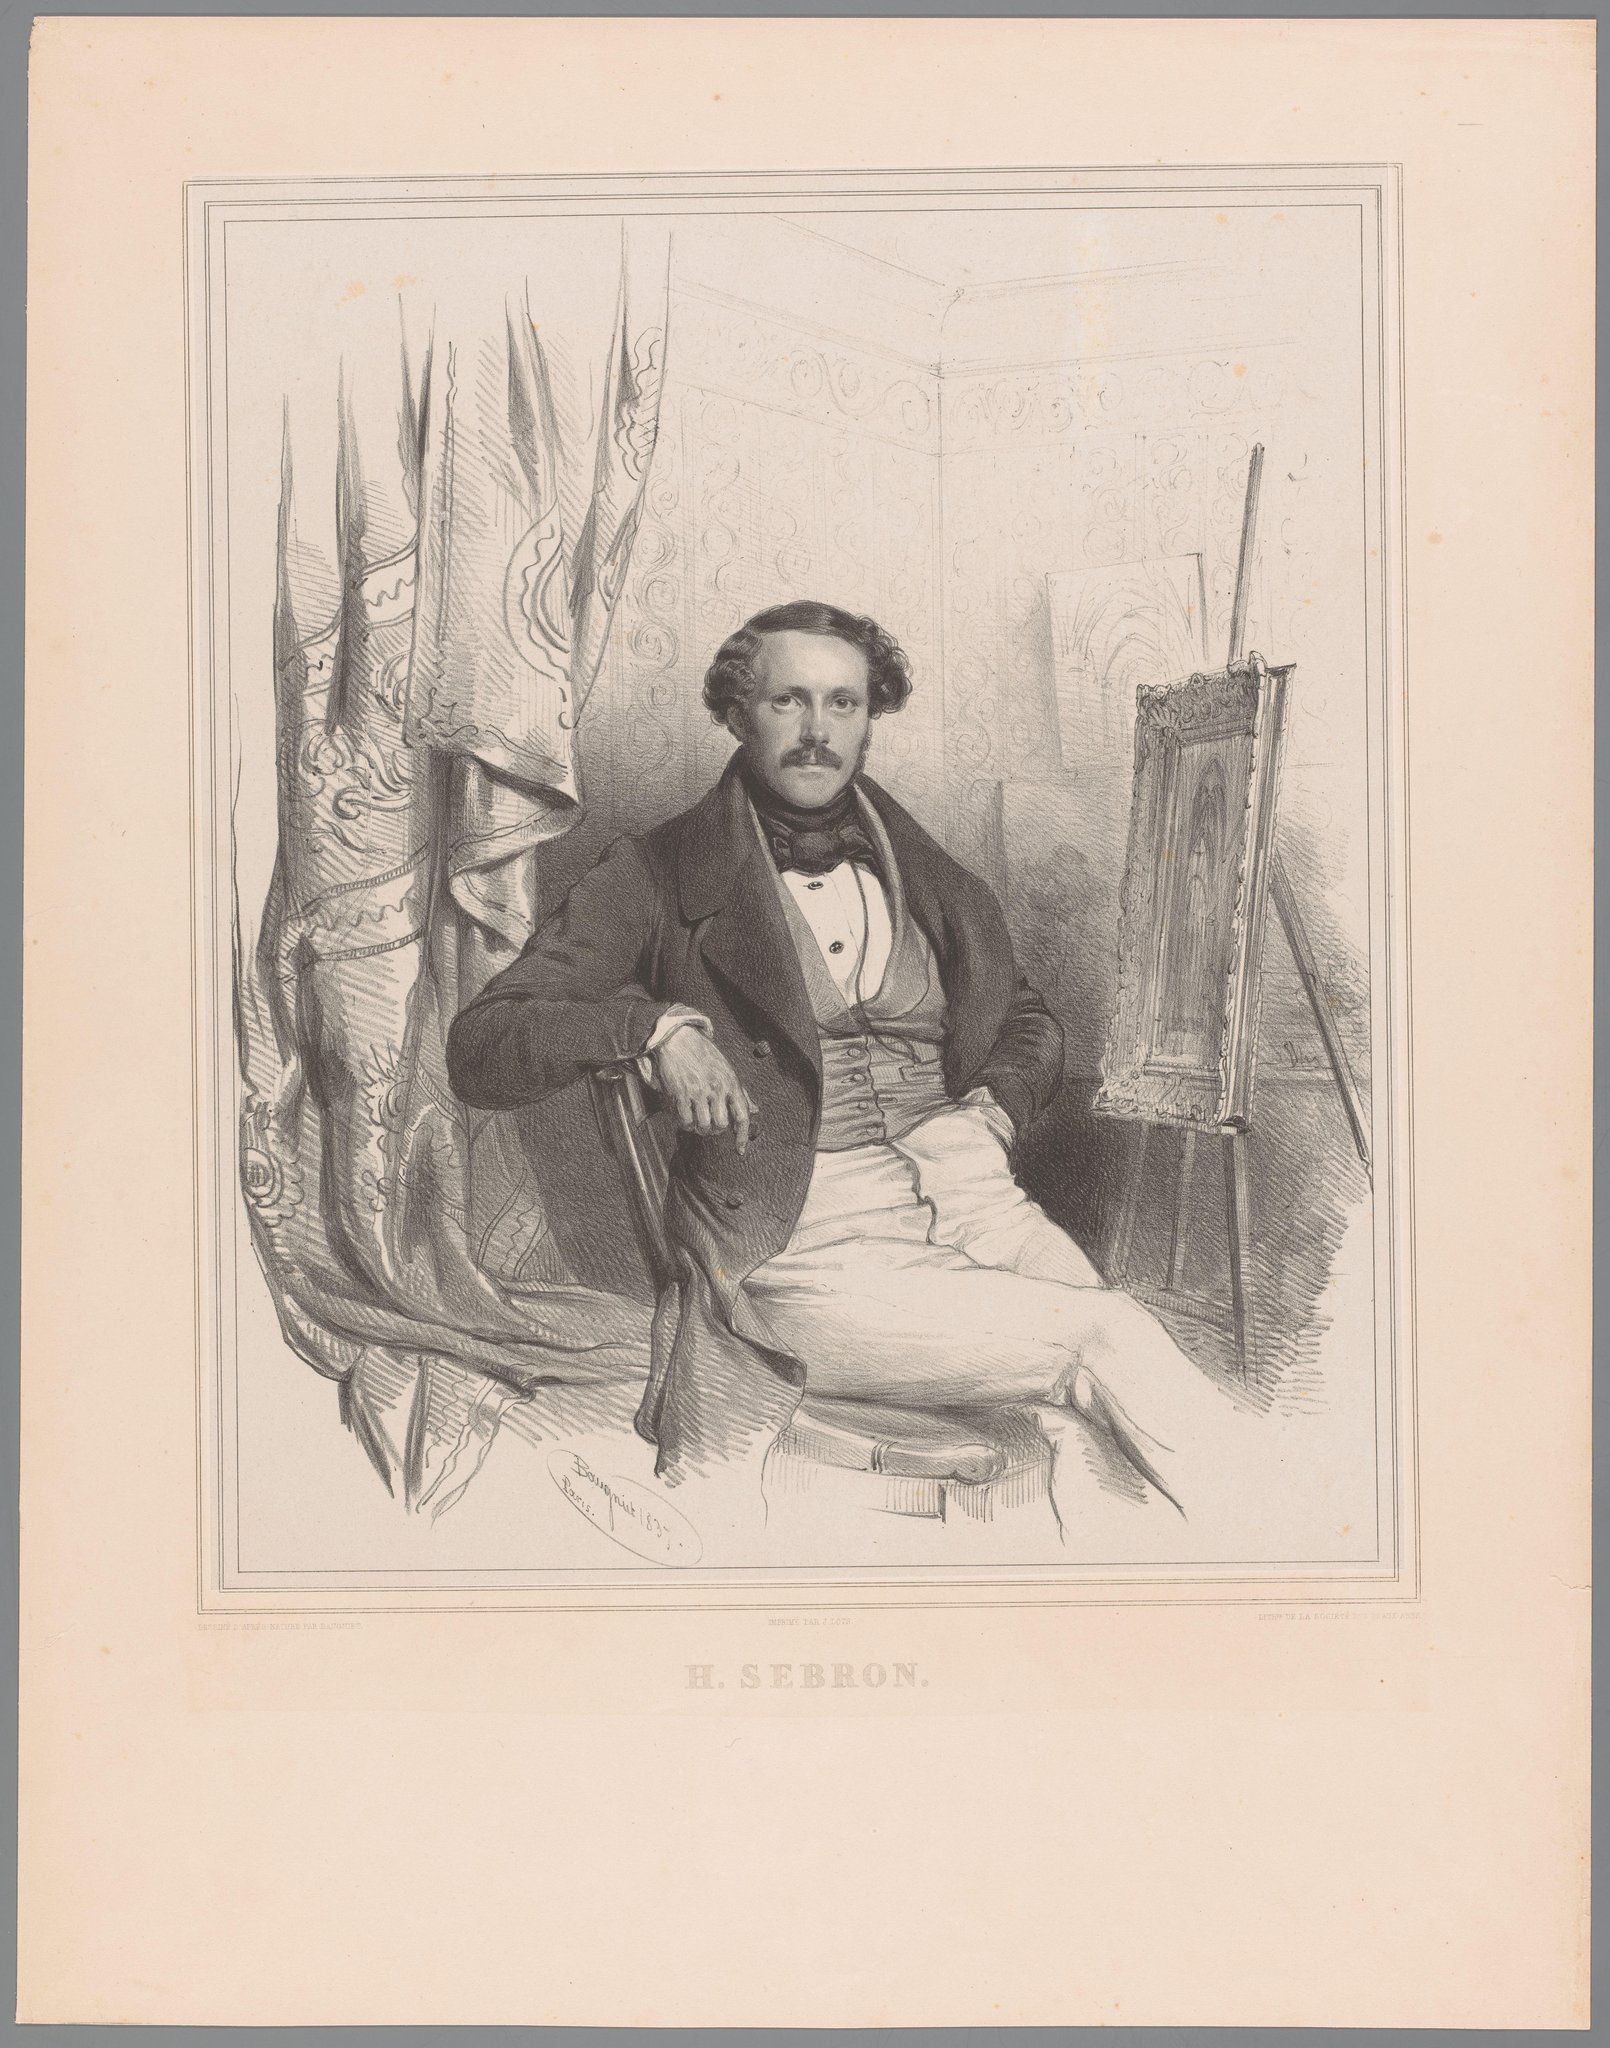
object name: print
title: H. Sebron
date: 1837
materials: paper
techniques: lithograph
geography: brussels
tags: paris, draughtsman, hippolyte victor valentin sebron, adult man, historical persons, easel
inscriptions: collector's mark: Lugt 2228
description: Andere staat verschenen in: Baugniet, Charles. Les artistes contemporains: portraits lithographiés d'après nature, accompagnés de notices sur la vie et les ouvrages de chacun d'eux. Brussel: De Wasme-Pletinckx, [1836-1840].